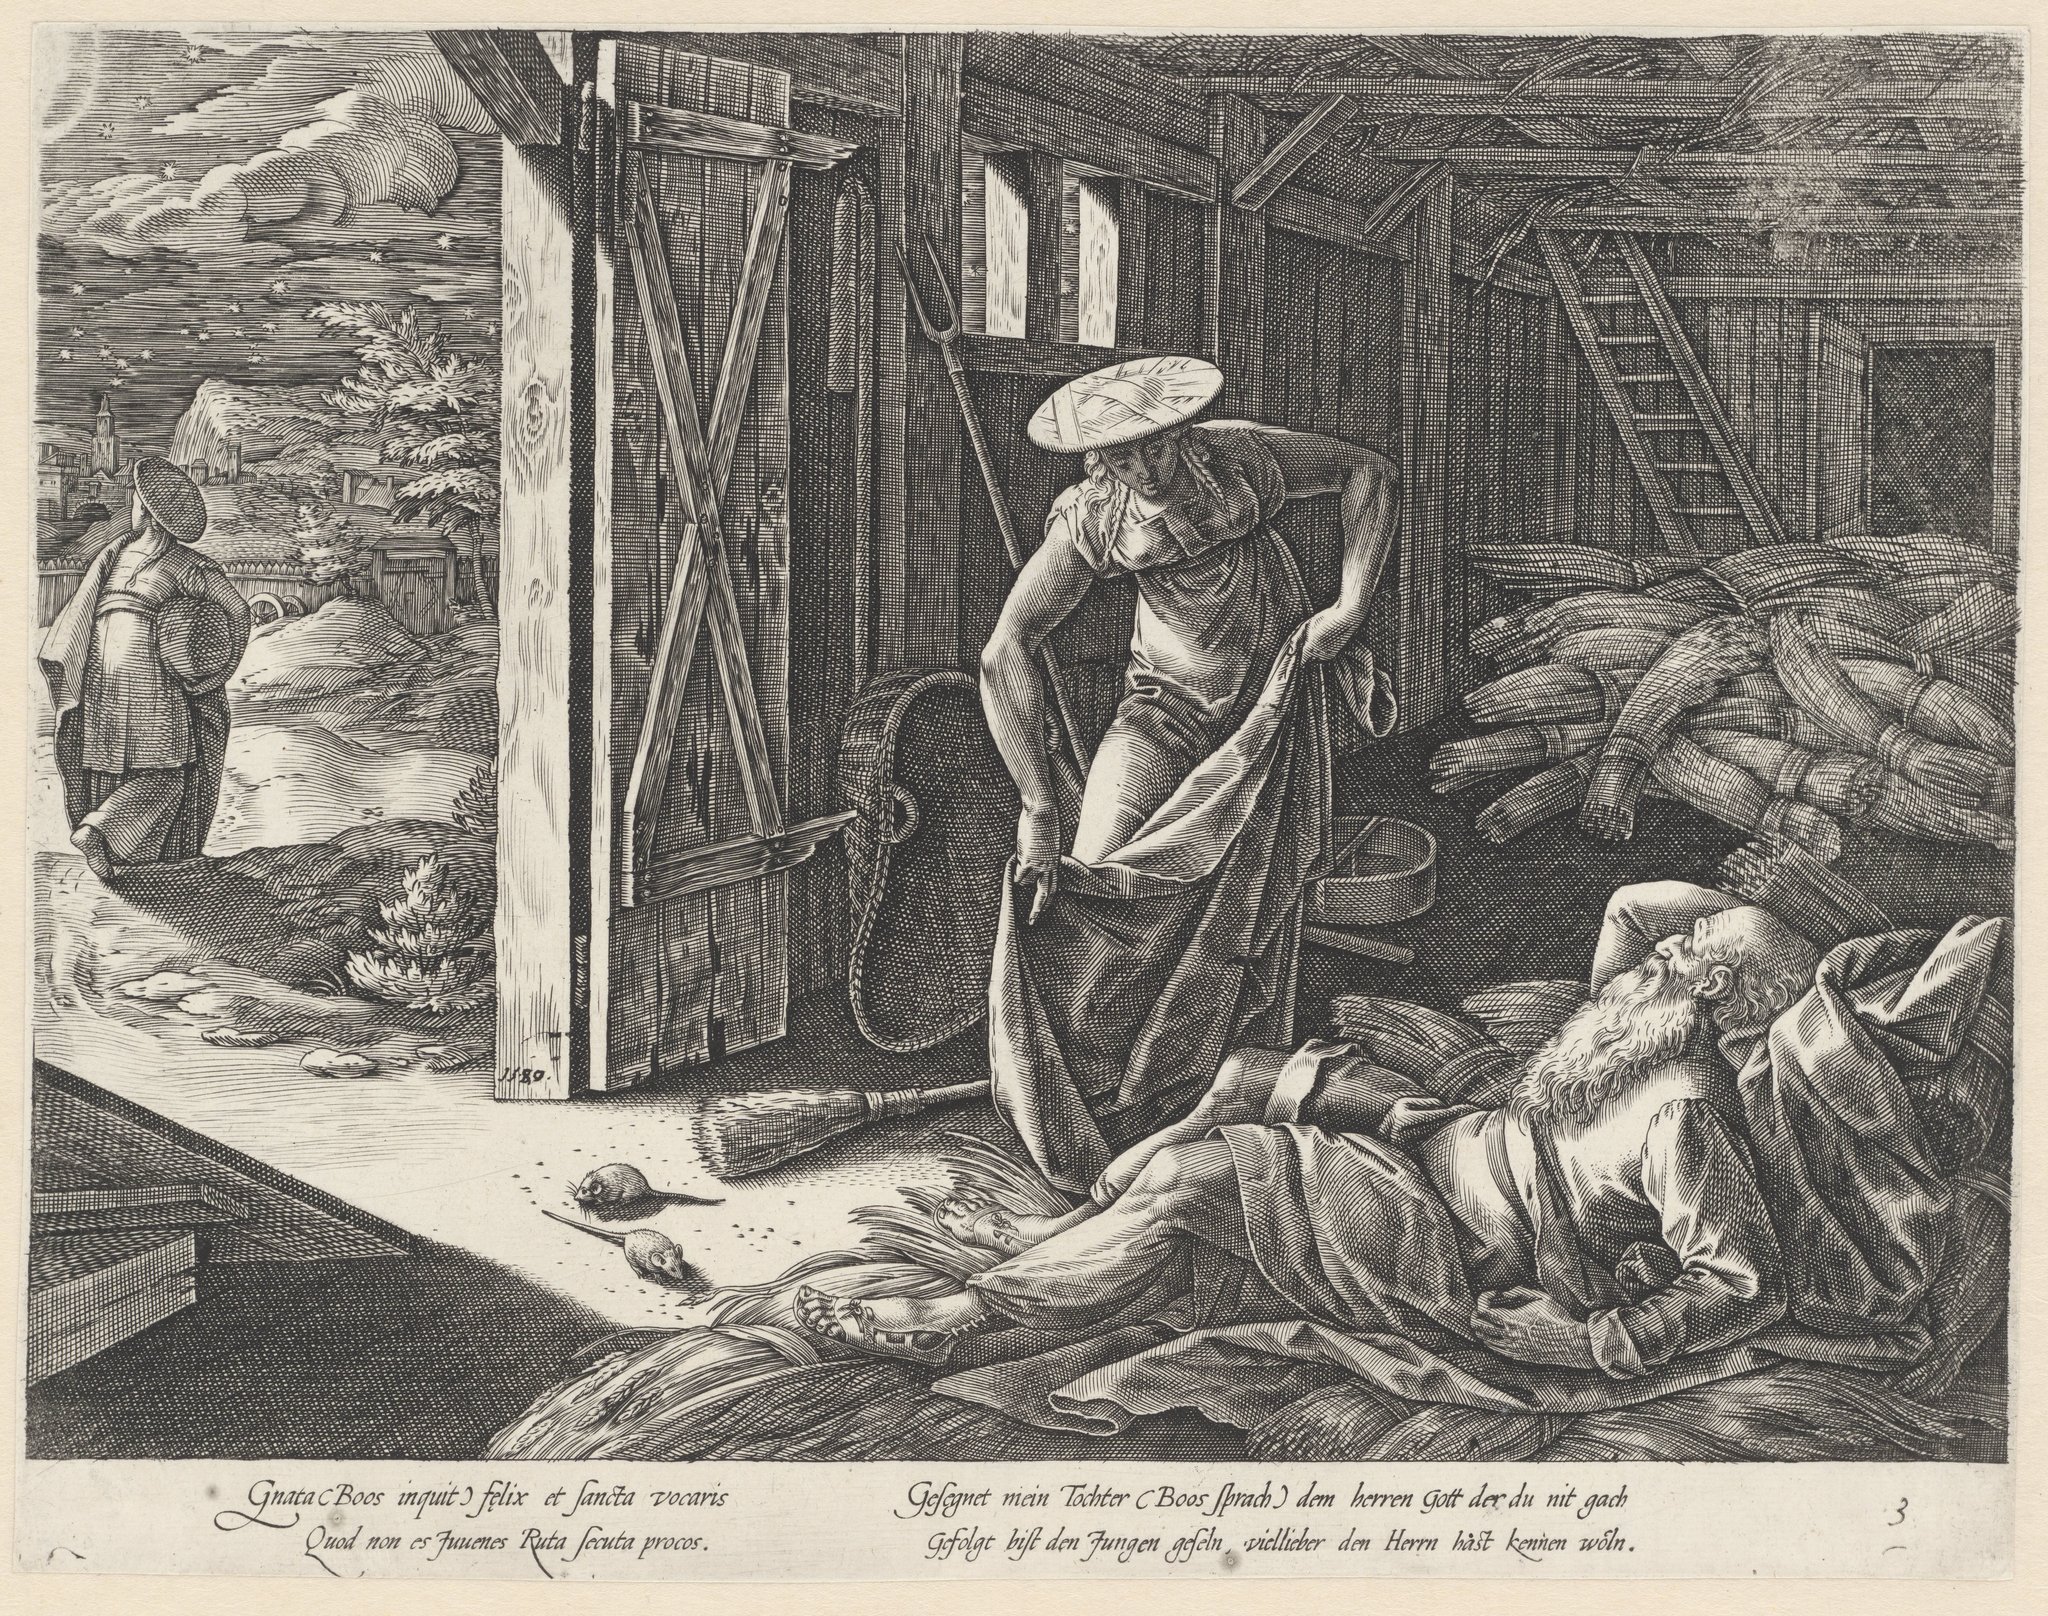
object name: print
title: De geschiedenis van Ruth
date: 1580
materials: paper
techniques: engraving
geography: haarlem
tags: ruth uncovers the feet of the sleeping boaz and lies down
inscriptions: date: ‘1580’, collector's mark: Lugt 2228, collector's mark: Lugt 2760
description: Ruth staat met een deken in de handen aan de voeten van de liggende Boaz in een graanschuur. Twee regels Latijn en twee regels Duits in marge onder prent.